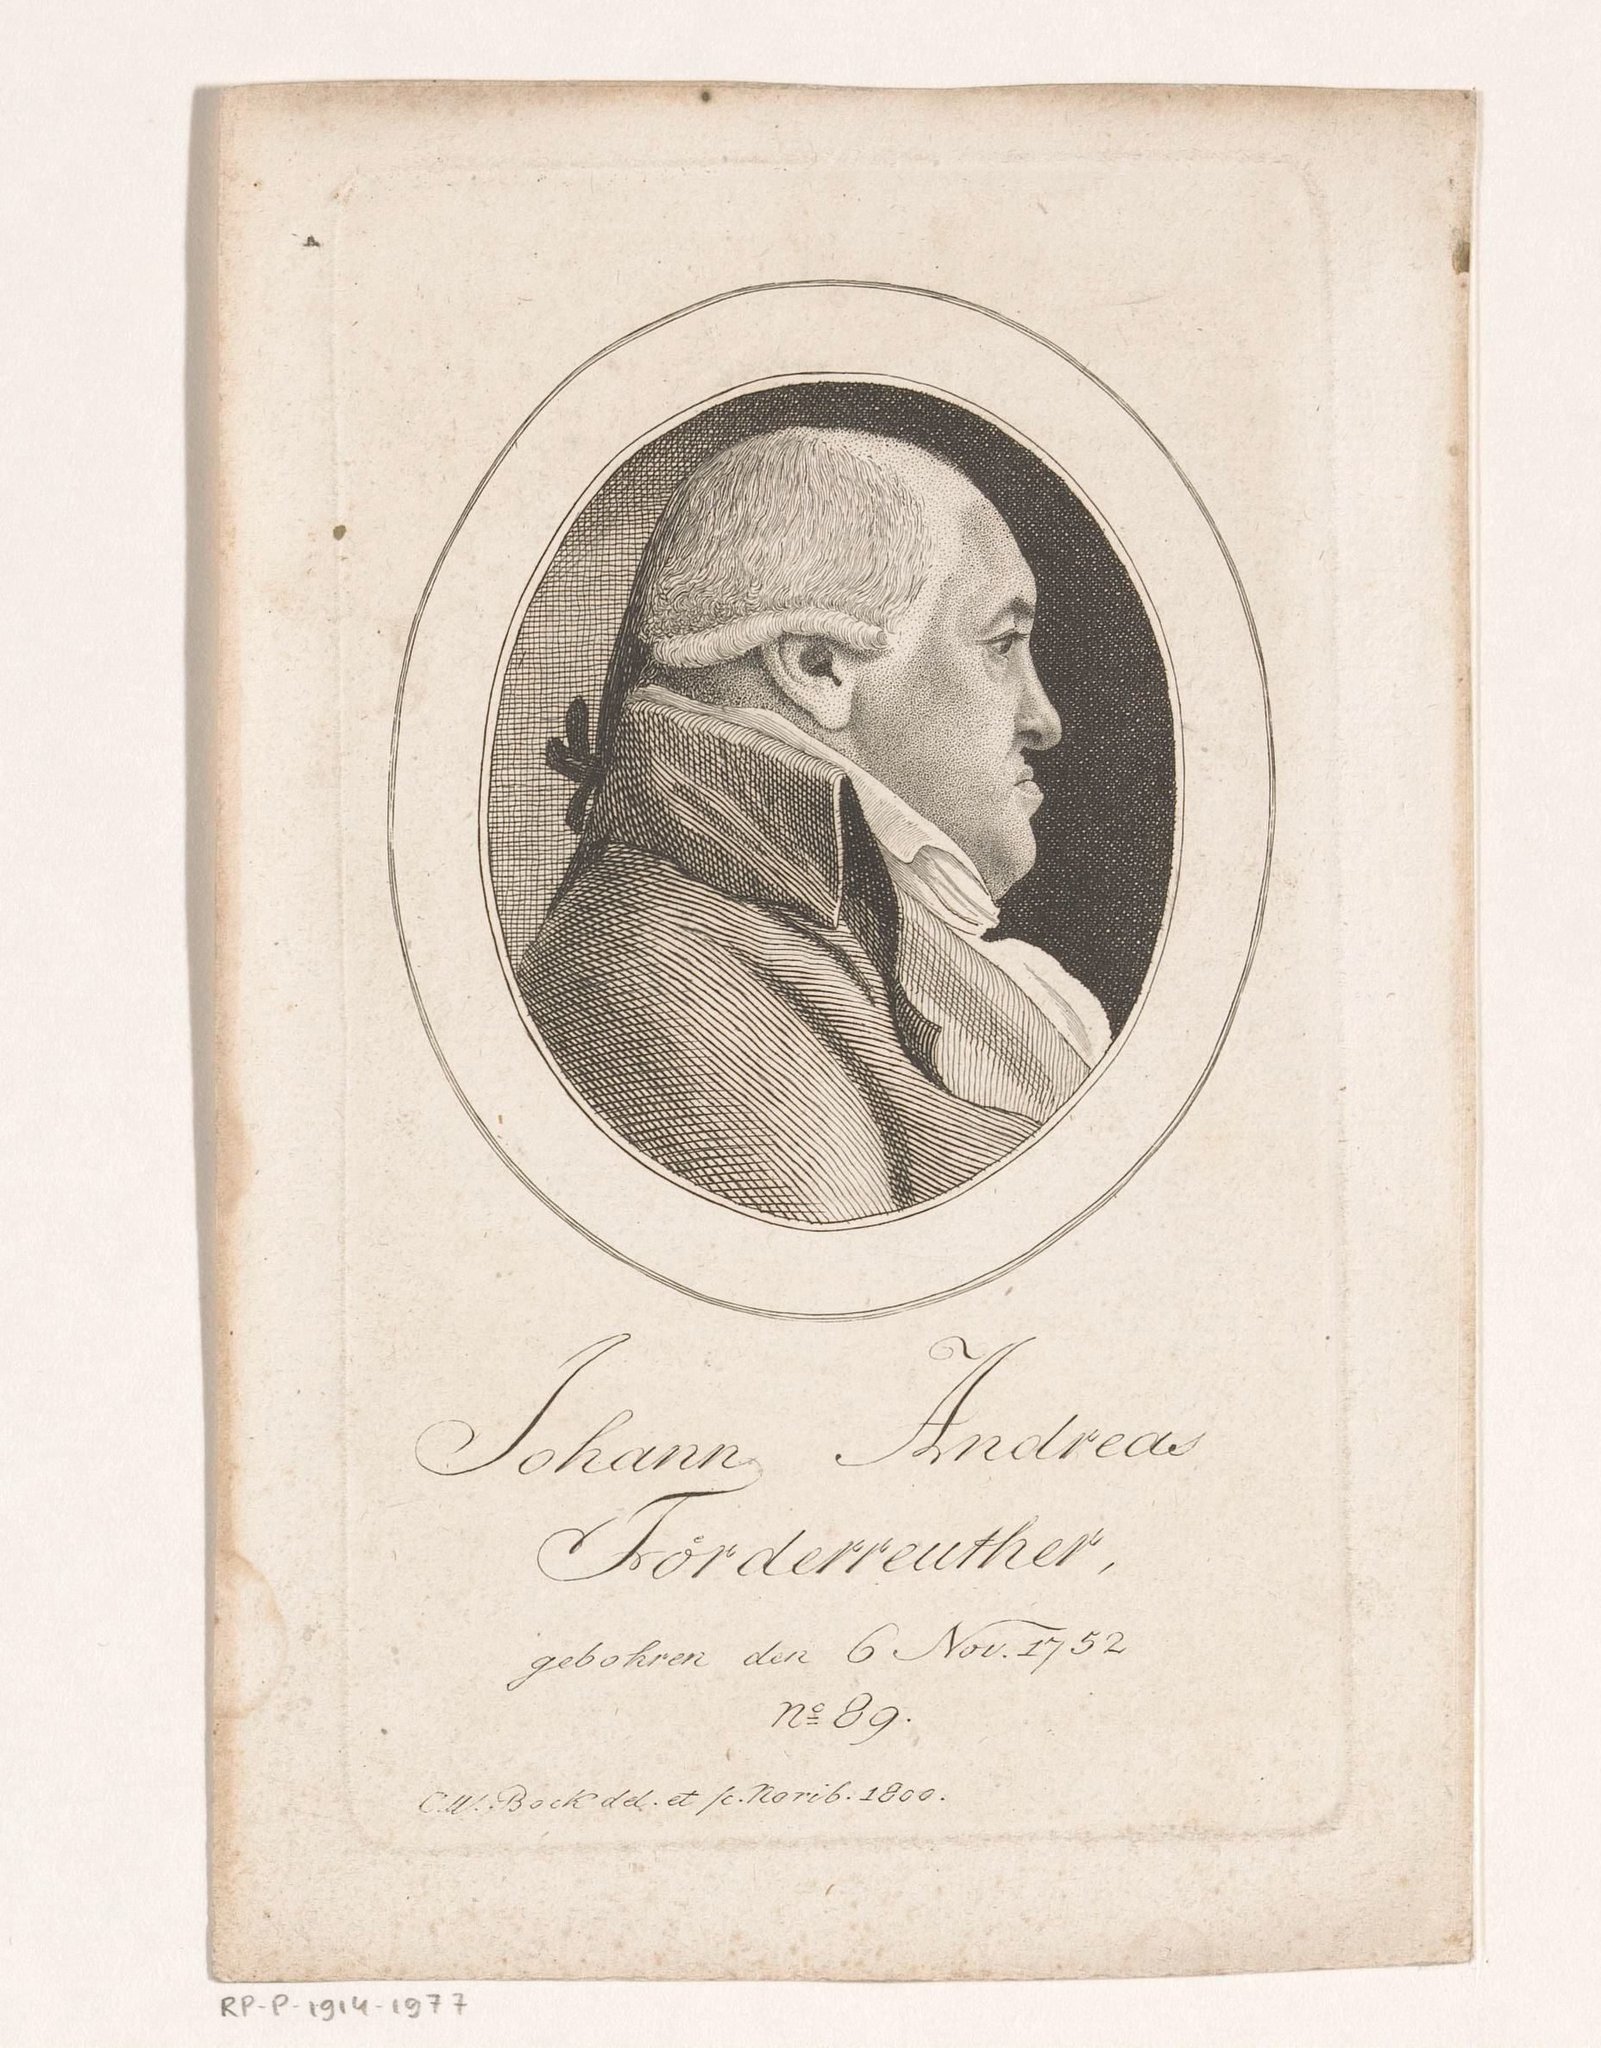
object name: print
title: Portret van Johann Andreas Förderreuther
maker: christoph wilhelm bock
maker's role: print maker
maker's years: 1755-1836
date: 1800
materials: paper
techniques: engraving, etching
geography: nuremberg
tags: historical persons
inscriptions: collector's mark: Lugt 2228